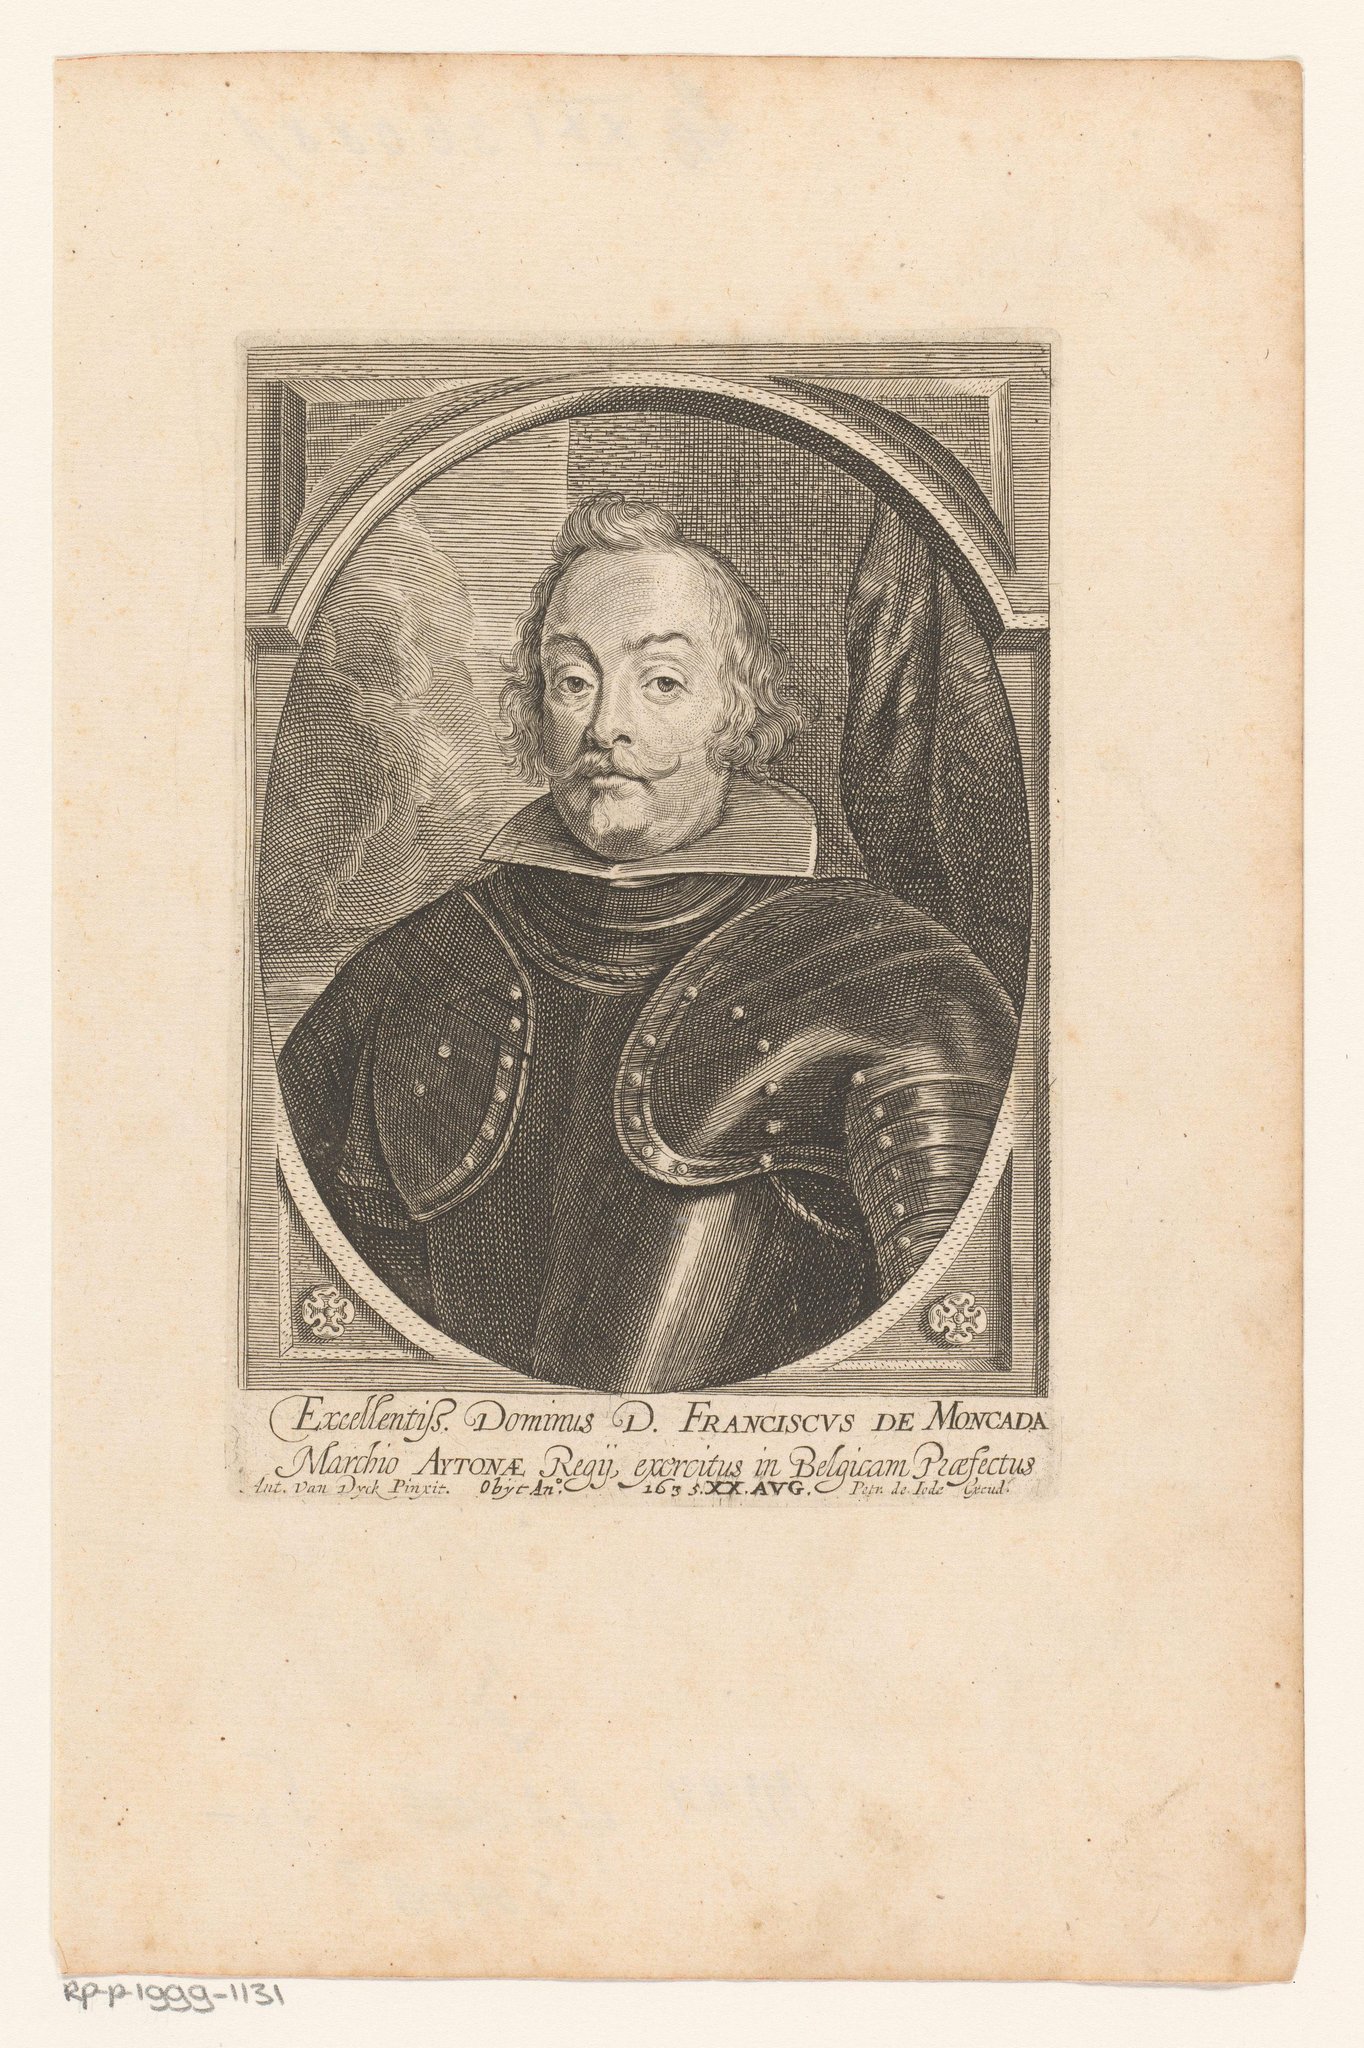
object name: print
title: Portret van Franciscus de Moncada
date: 1628-1670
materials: paper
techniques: engraving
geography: antwerp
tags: brussels, francisco de moncada (markies van aytona), armour, historical persons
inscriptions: collector's mark: Lugt 2228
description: Met tweeregelig onderschrift in het Latijn.